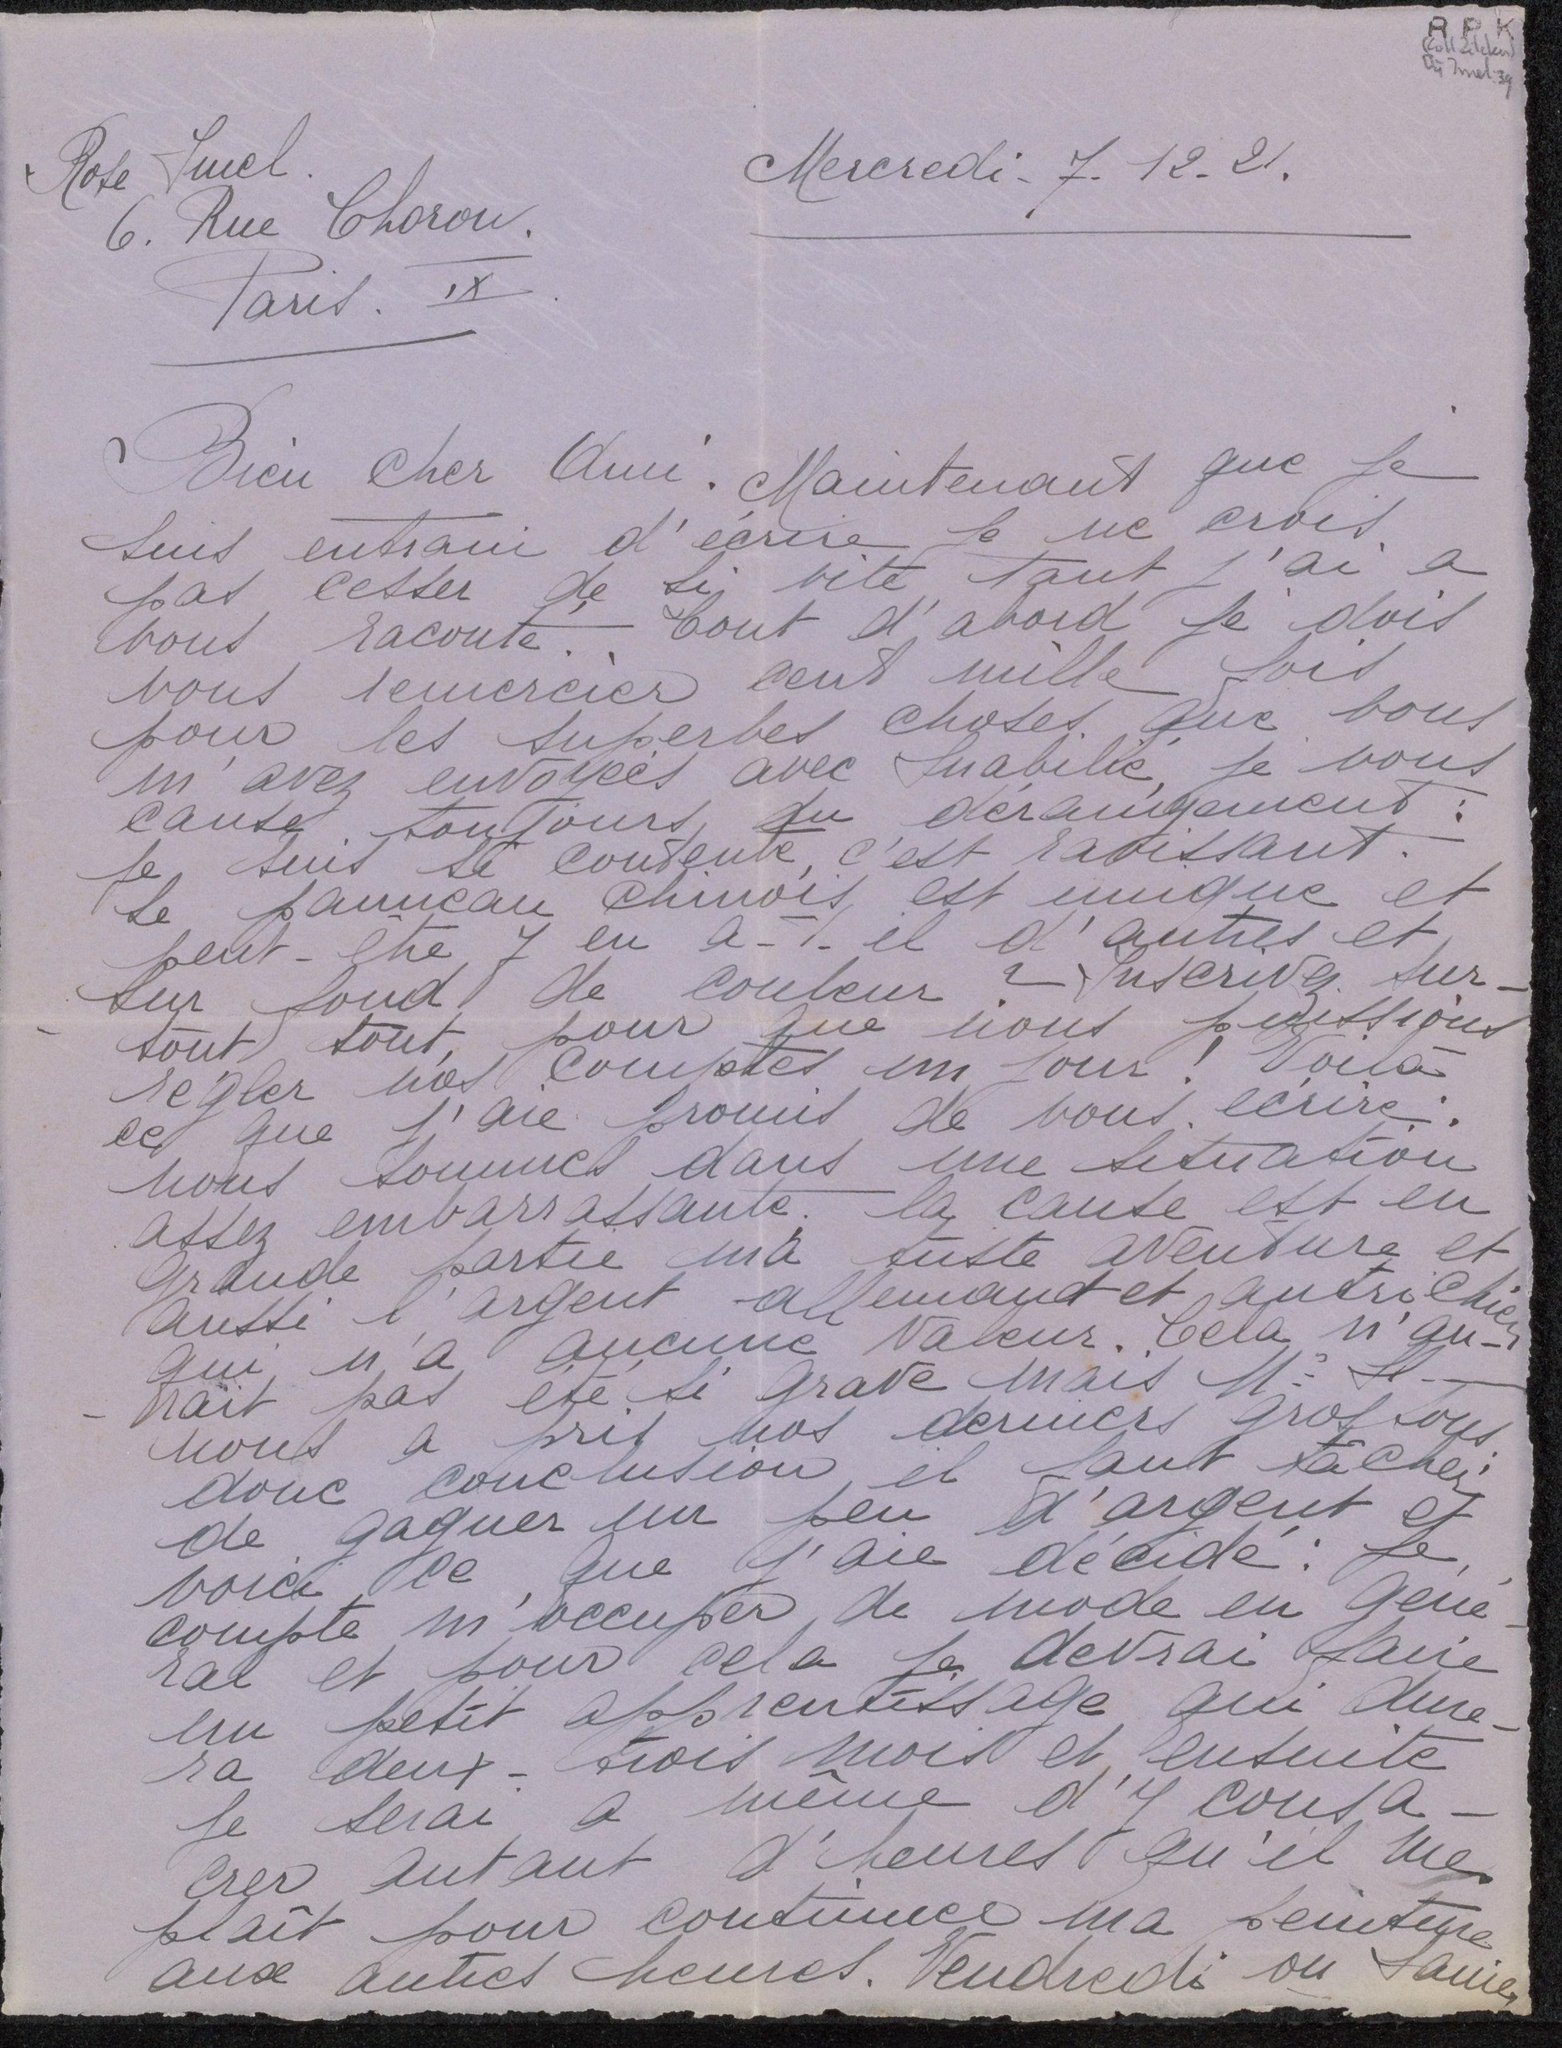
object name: letter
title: Brief aan Philip Zilcken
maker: rose imel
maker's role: draughtsman, painter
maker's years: 1901-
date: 1921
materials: ink, paper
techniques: pen, writing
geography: paris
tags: the hague, painter, draughtsman, philip zilcken, money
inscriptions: collector's mark: ‘RPK’